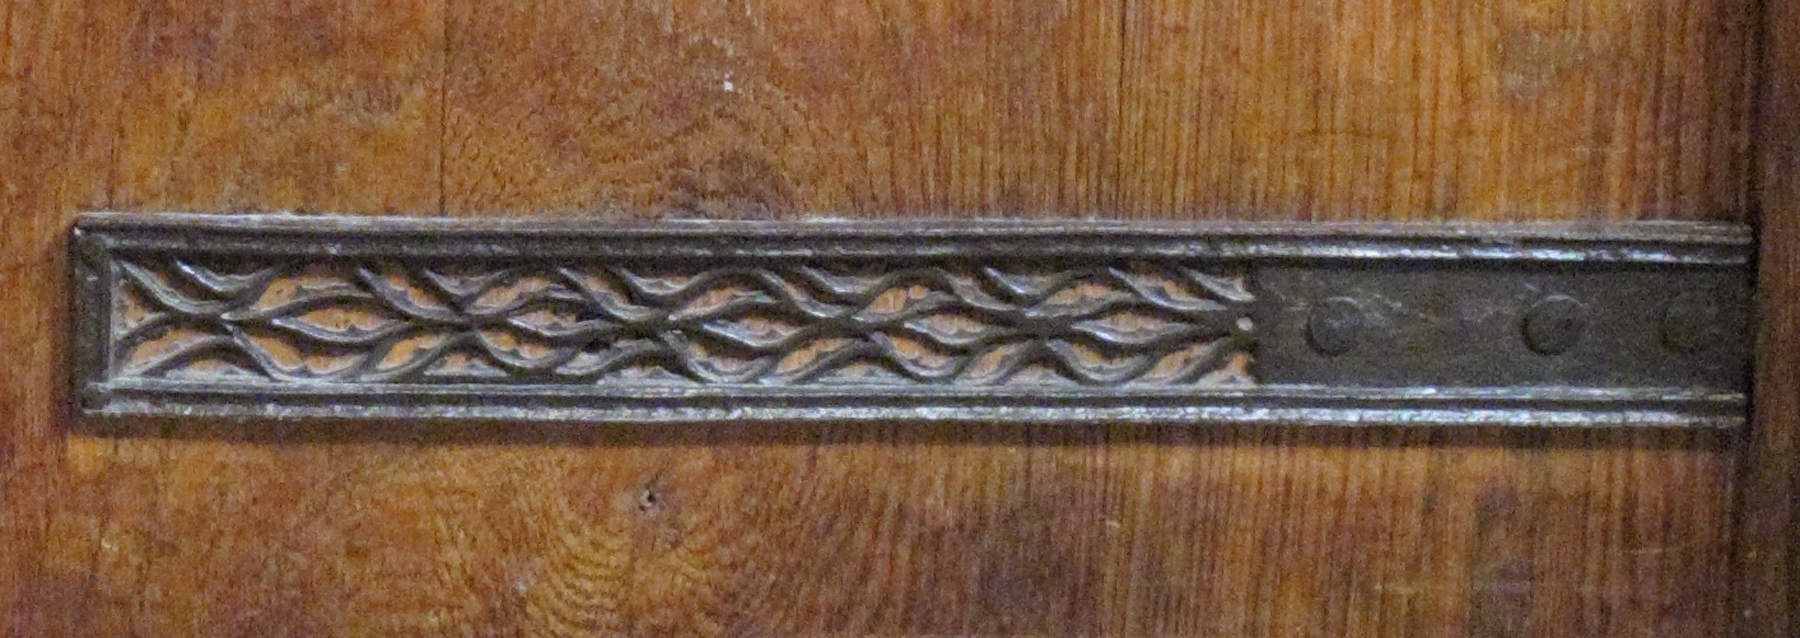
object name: strap hinge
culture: european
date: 1401-1600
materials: iron